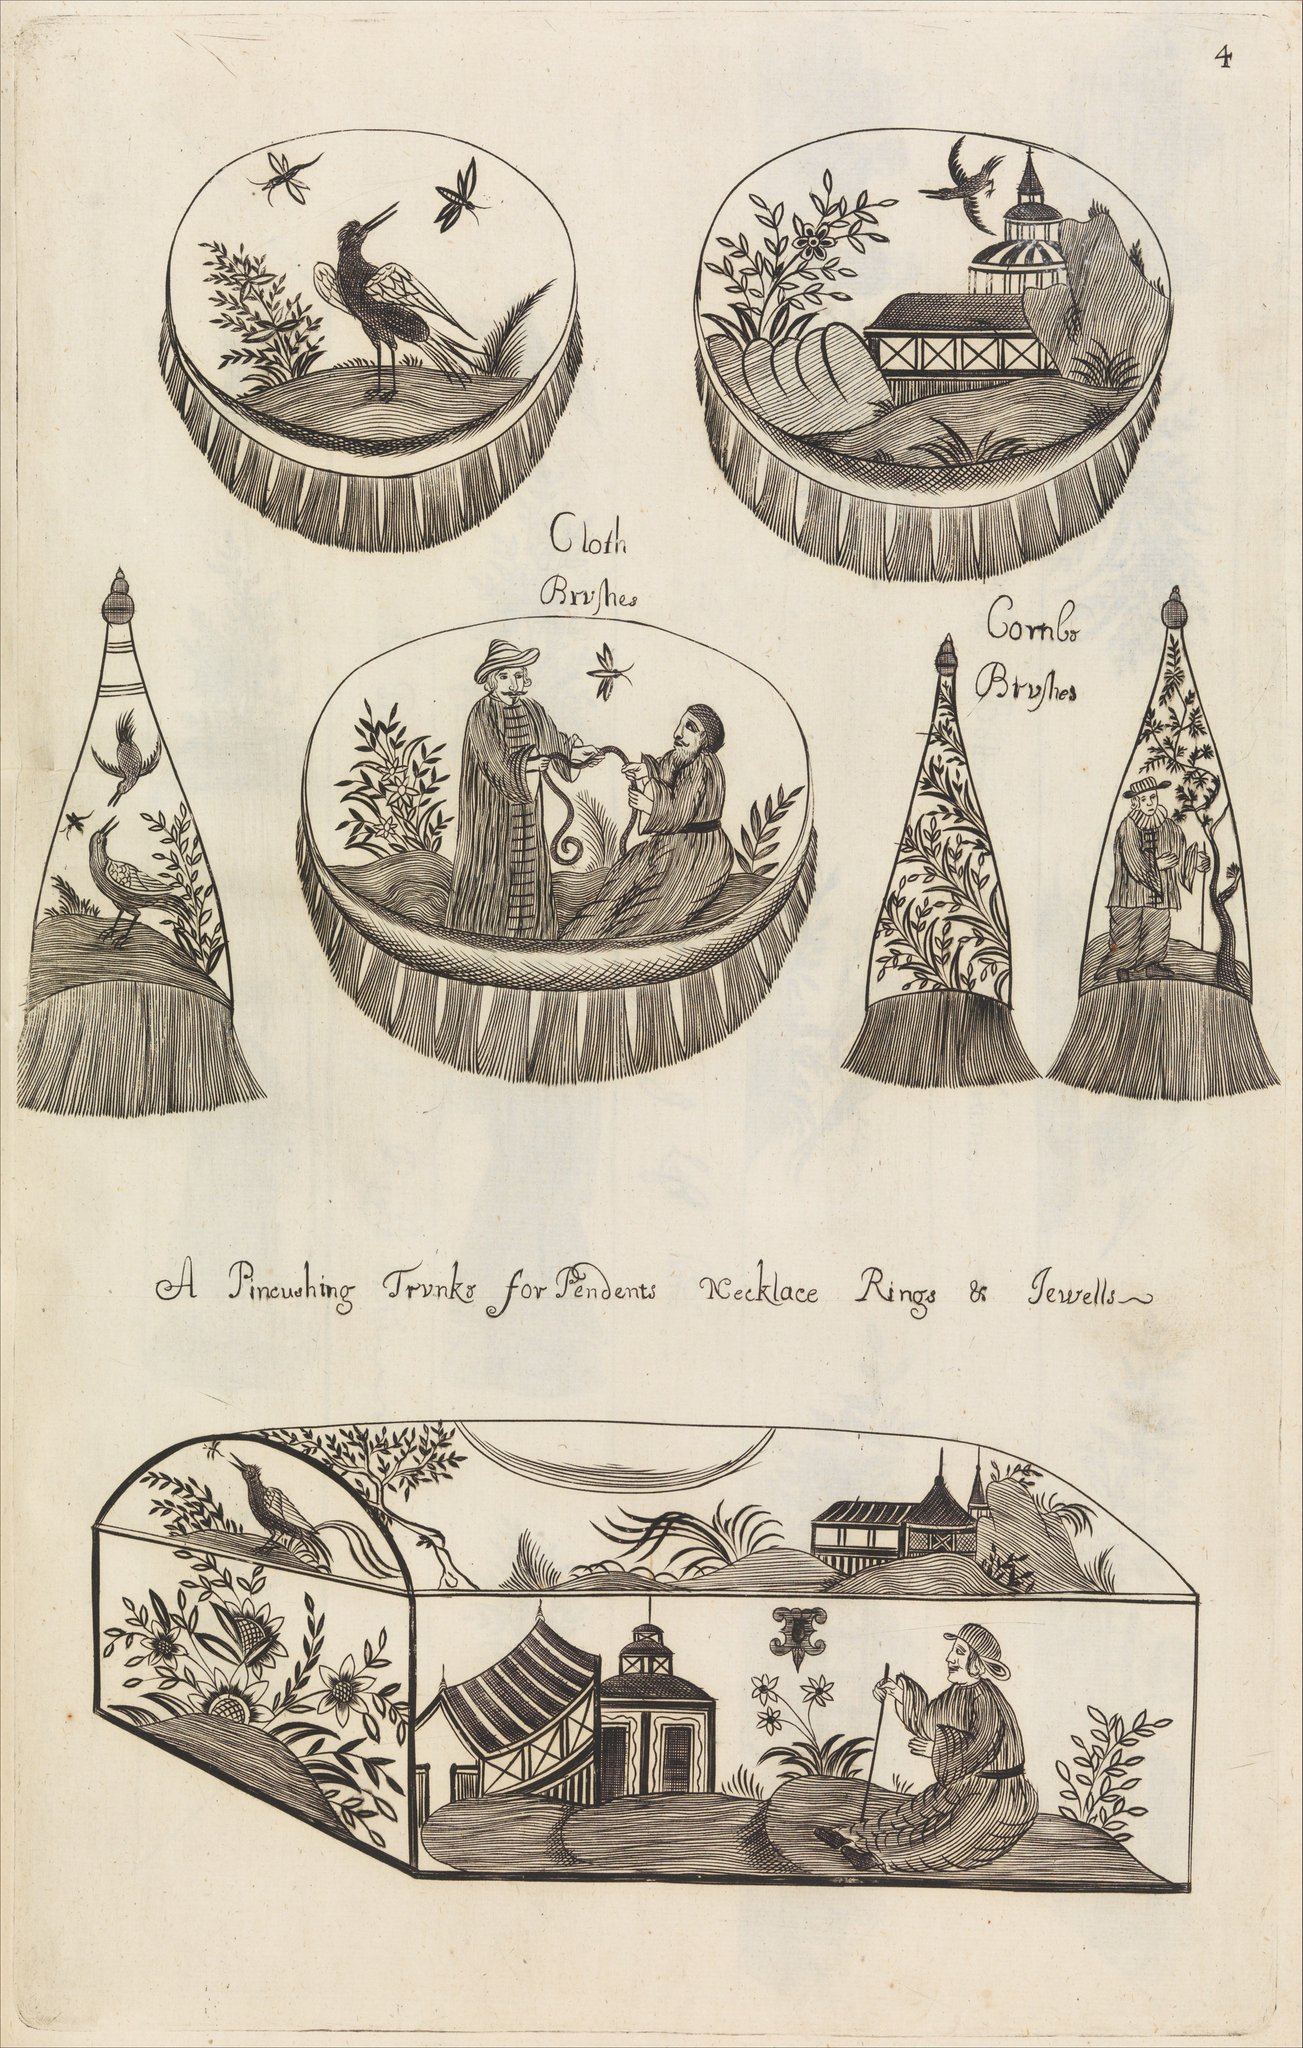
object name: ornament architecture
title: A Treatise of Japanning and Varnishing...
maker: john stalker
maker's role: author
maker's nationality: british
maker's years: 1600-1700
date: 1688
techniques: engraving, etching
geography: england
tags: birds,men